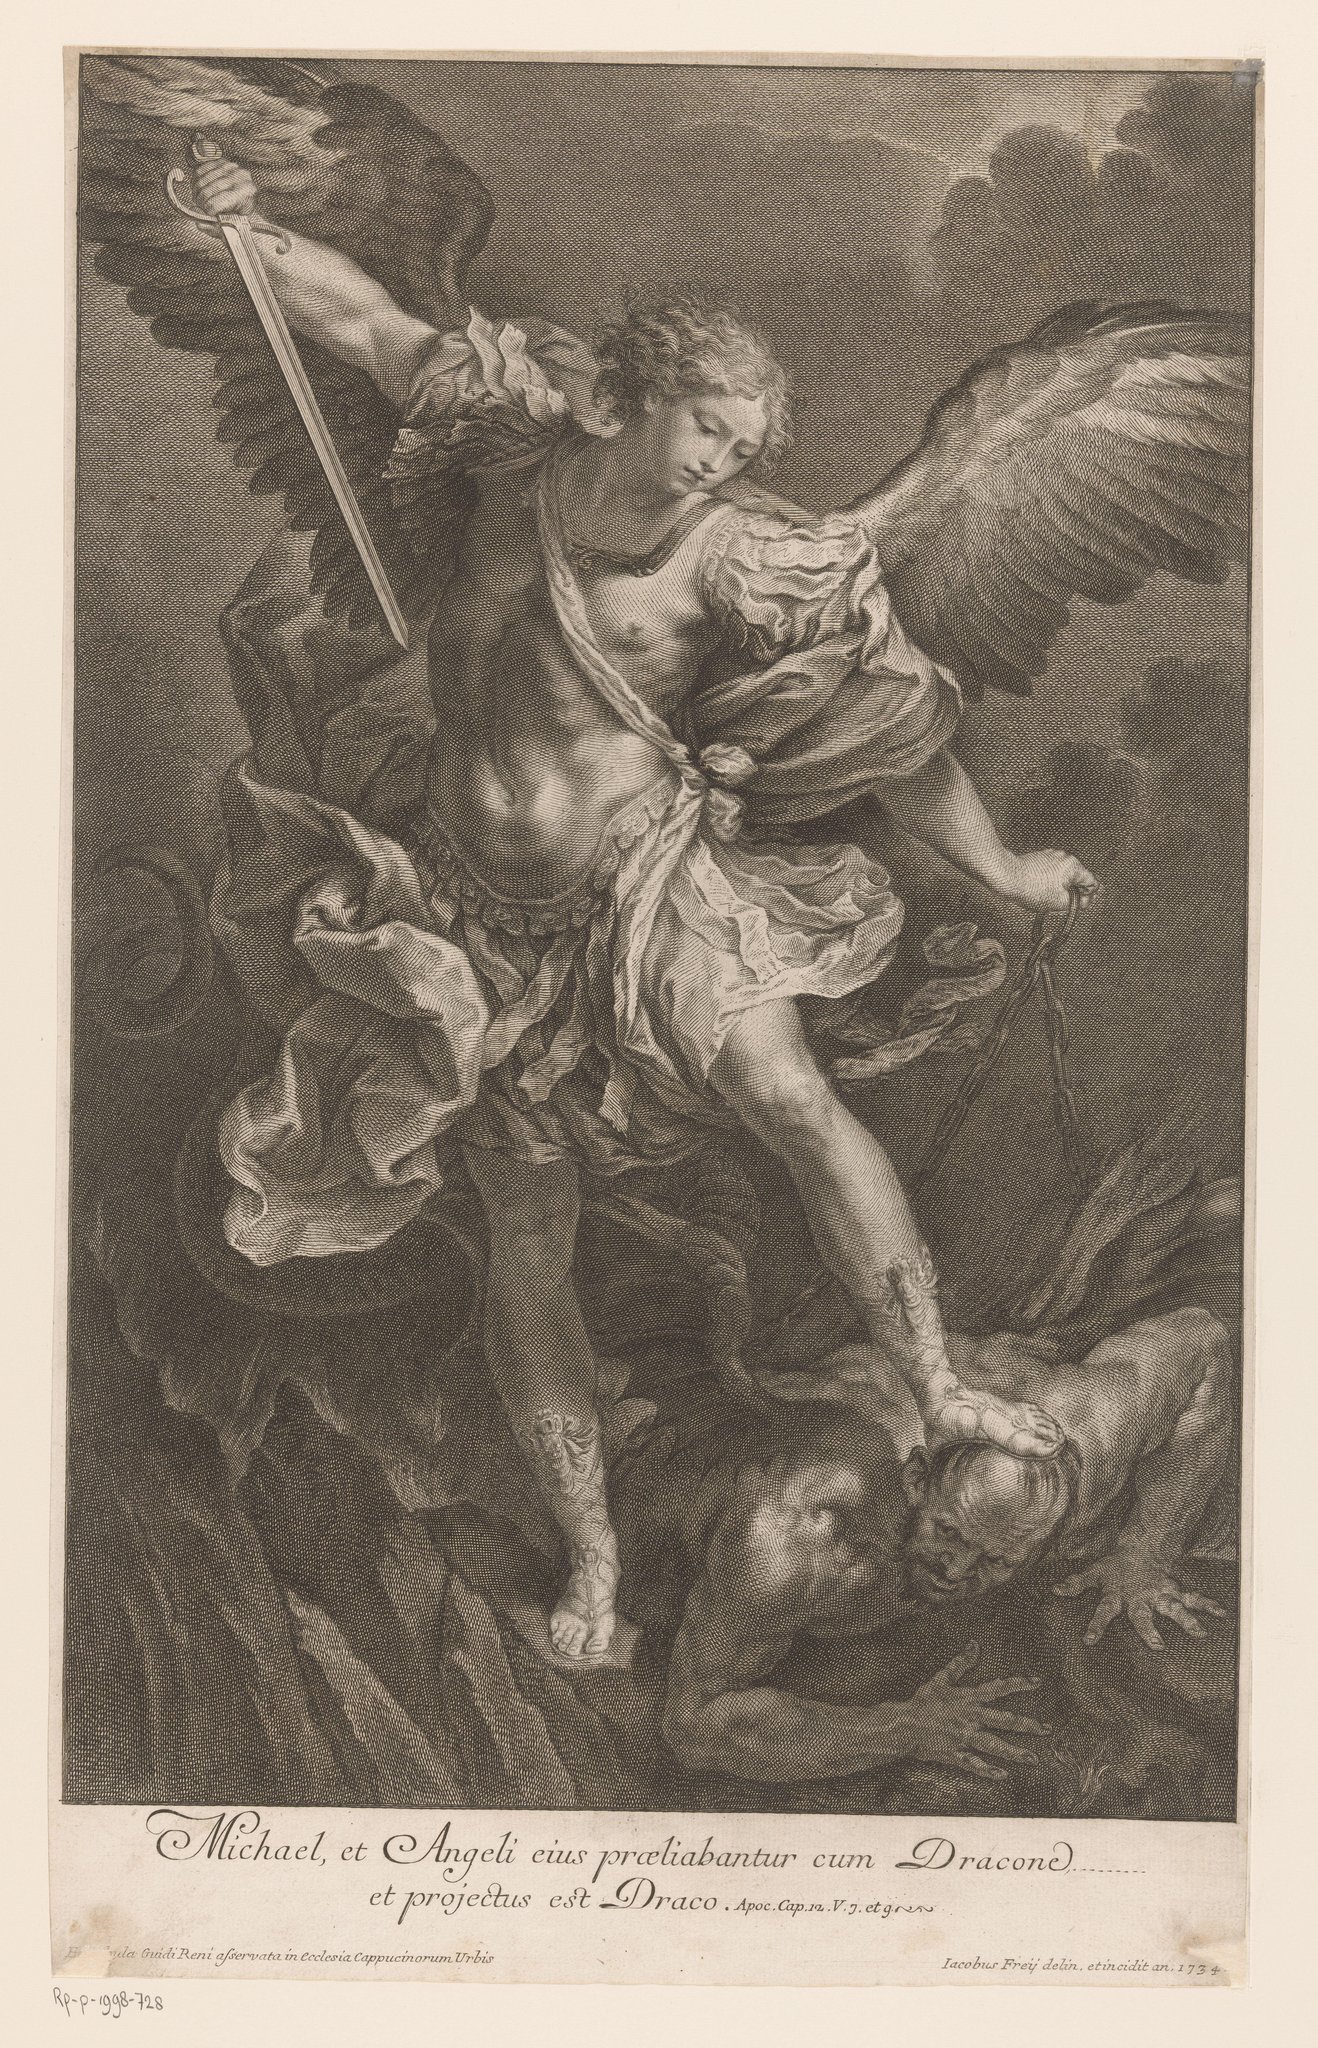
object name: print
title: Aartsengel Michaël en de draak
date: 1734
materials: paper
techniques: engraving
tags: the archangel michael fighting the dragon (devil, satan)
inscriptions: collector's mark: Lugt 2228